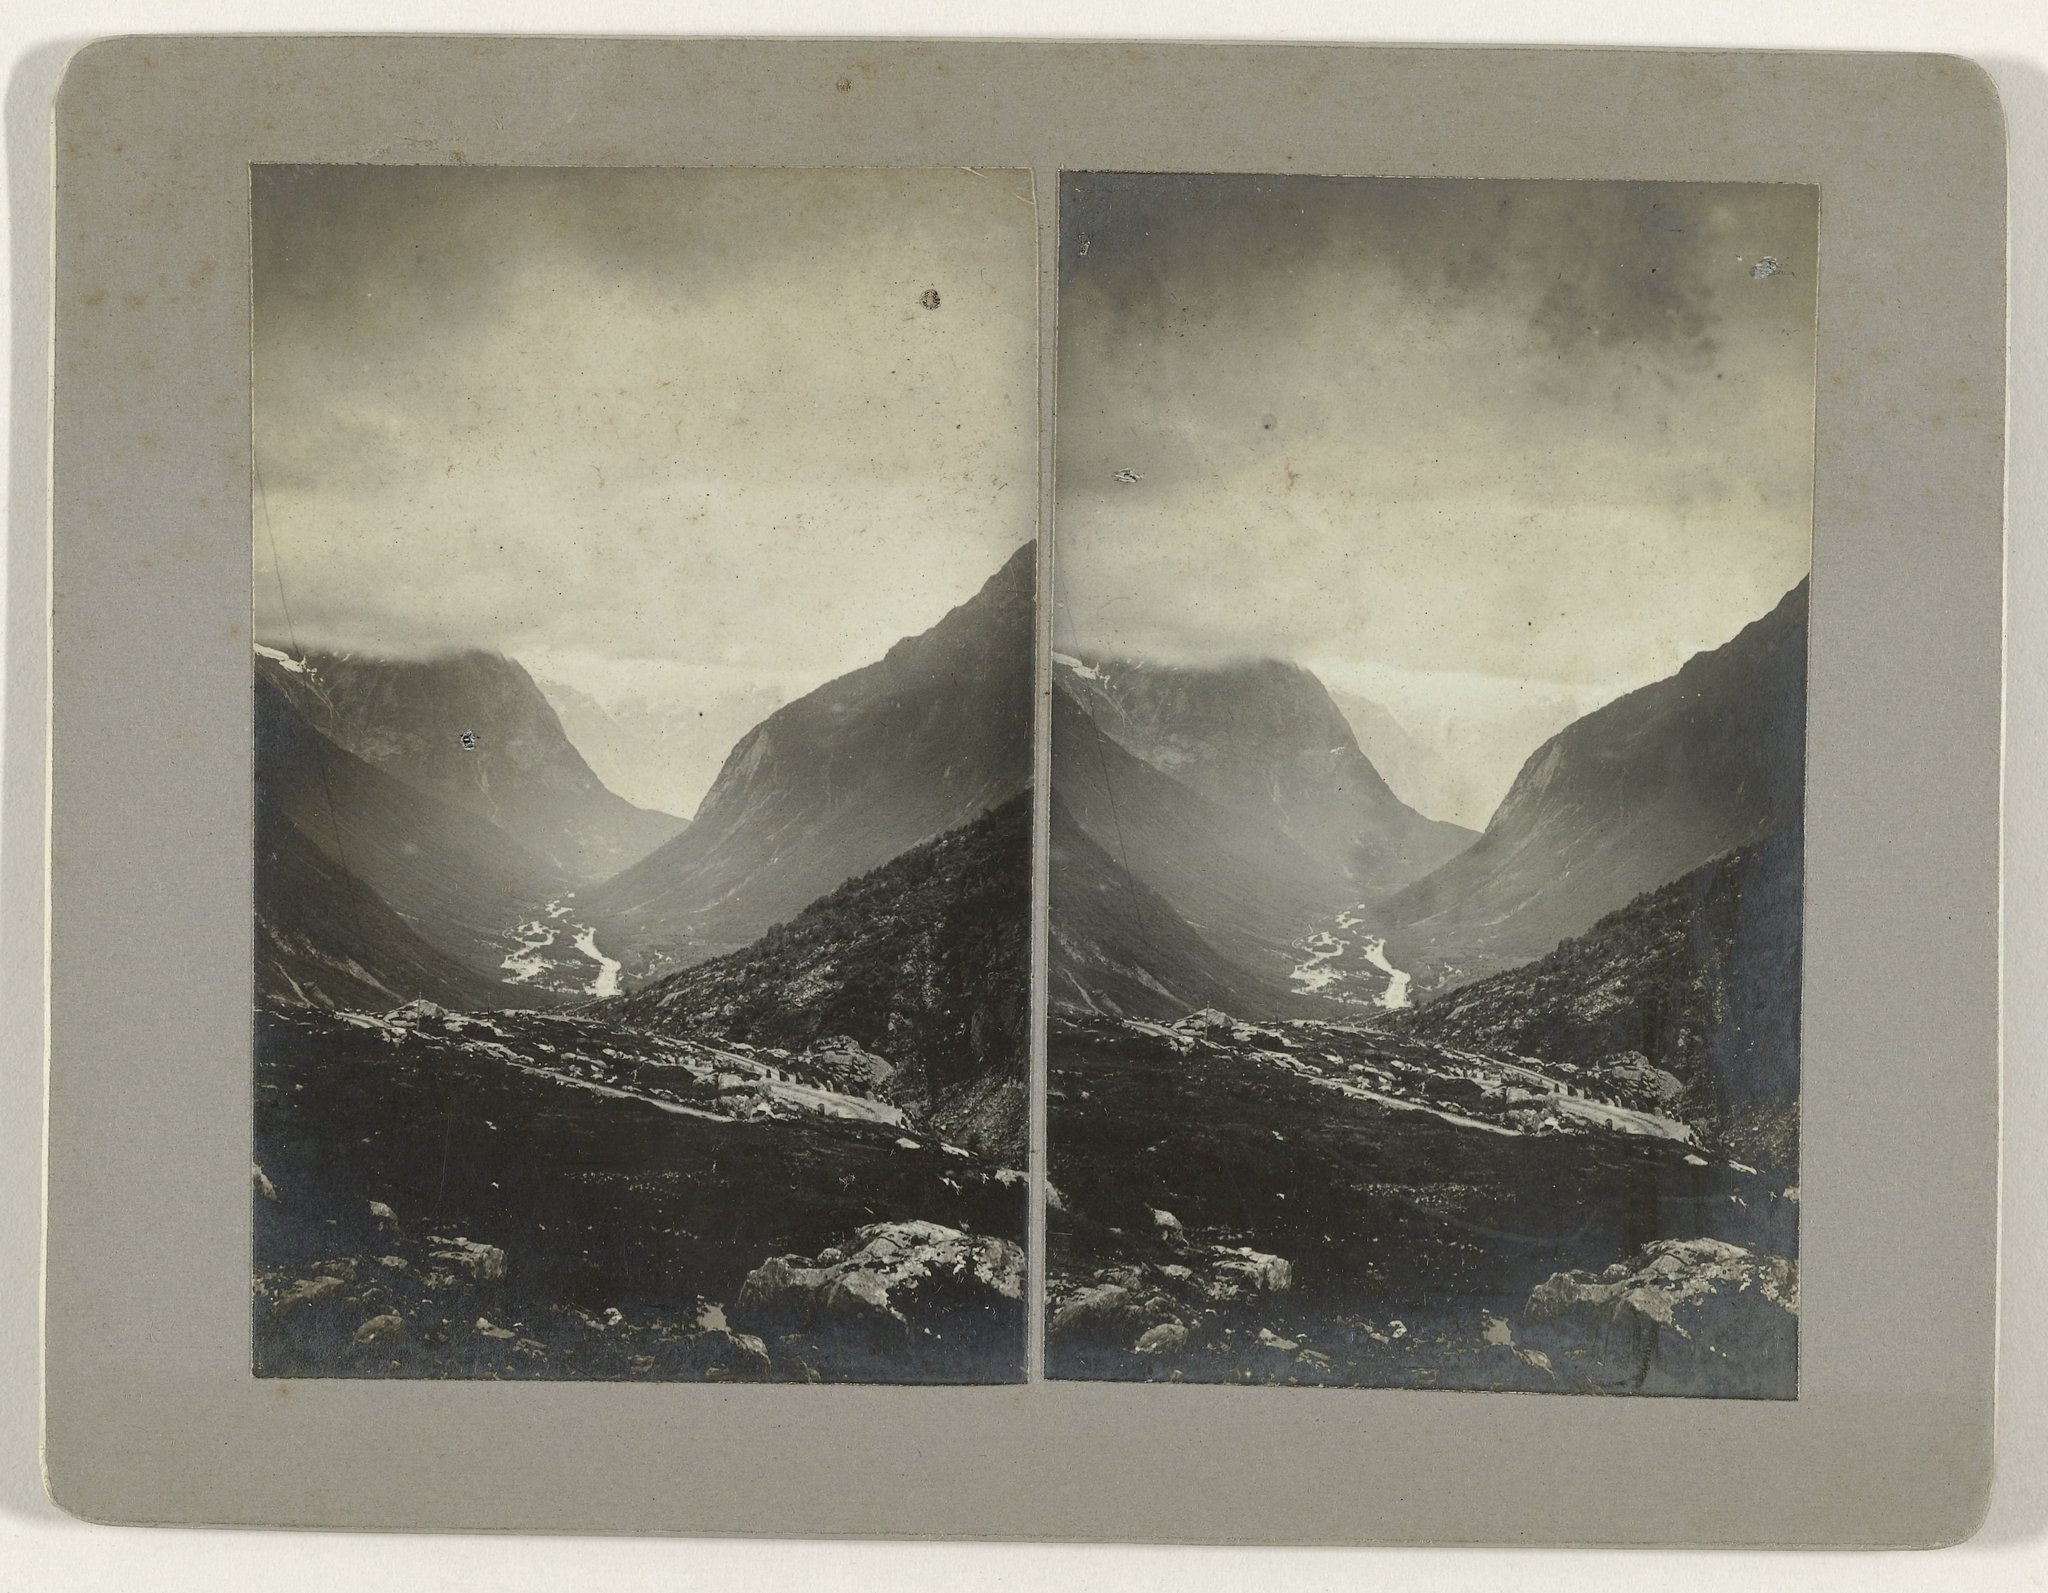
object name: stereograph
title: Noorwegen 1909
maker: geldolph adriaan kessler (dolph)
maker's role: fotograaf, industrieel, voetballer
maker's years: 1884-1945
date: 1909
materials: paper, photographic support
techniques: collodion silver print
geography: austria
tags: norway